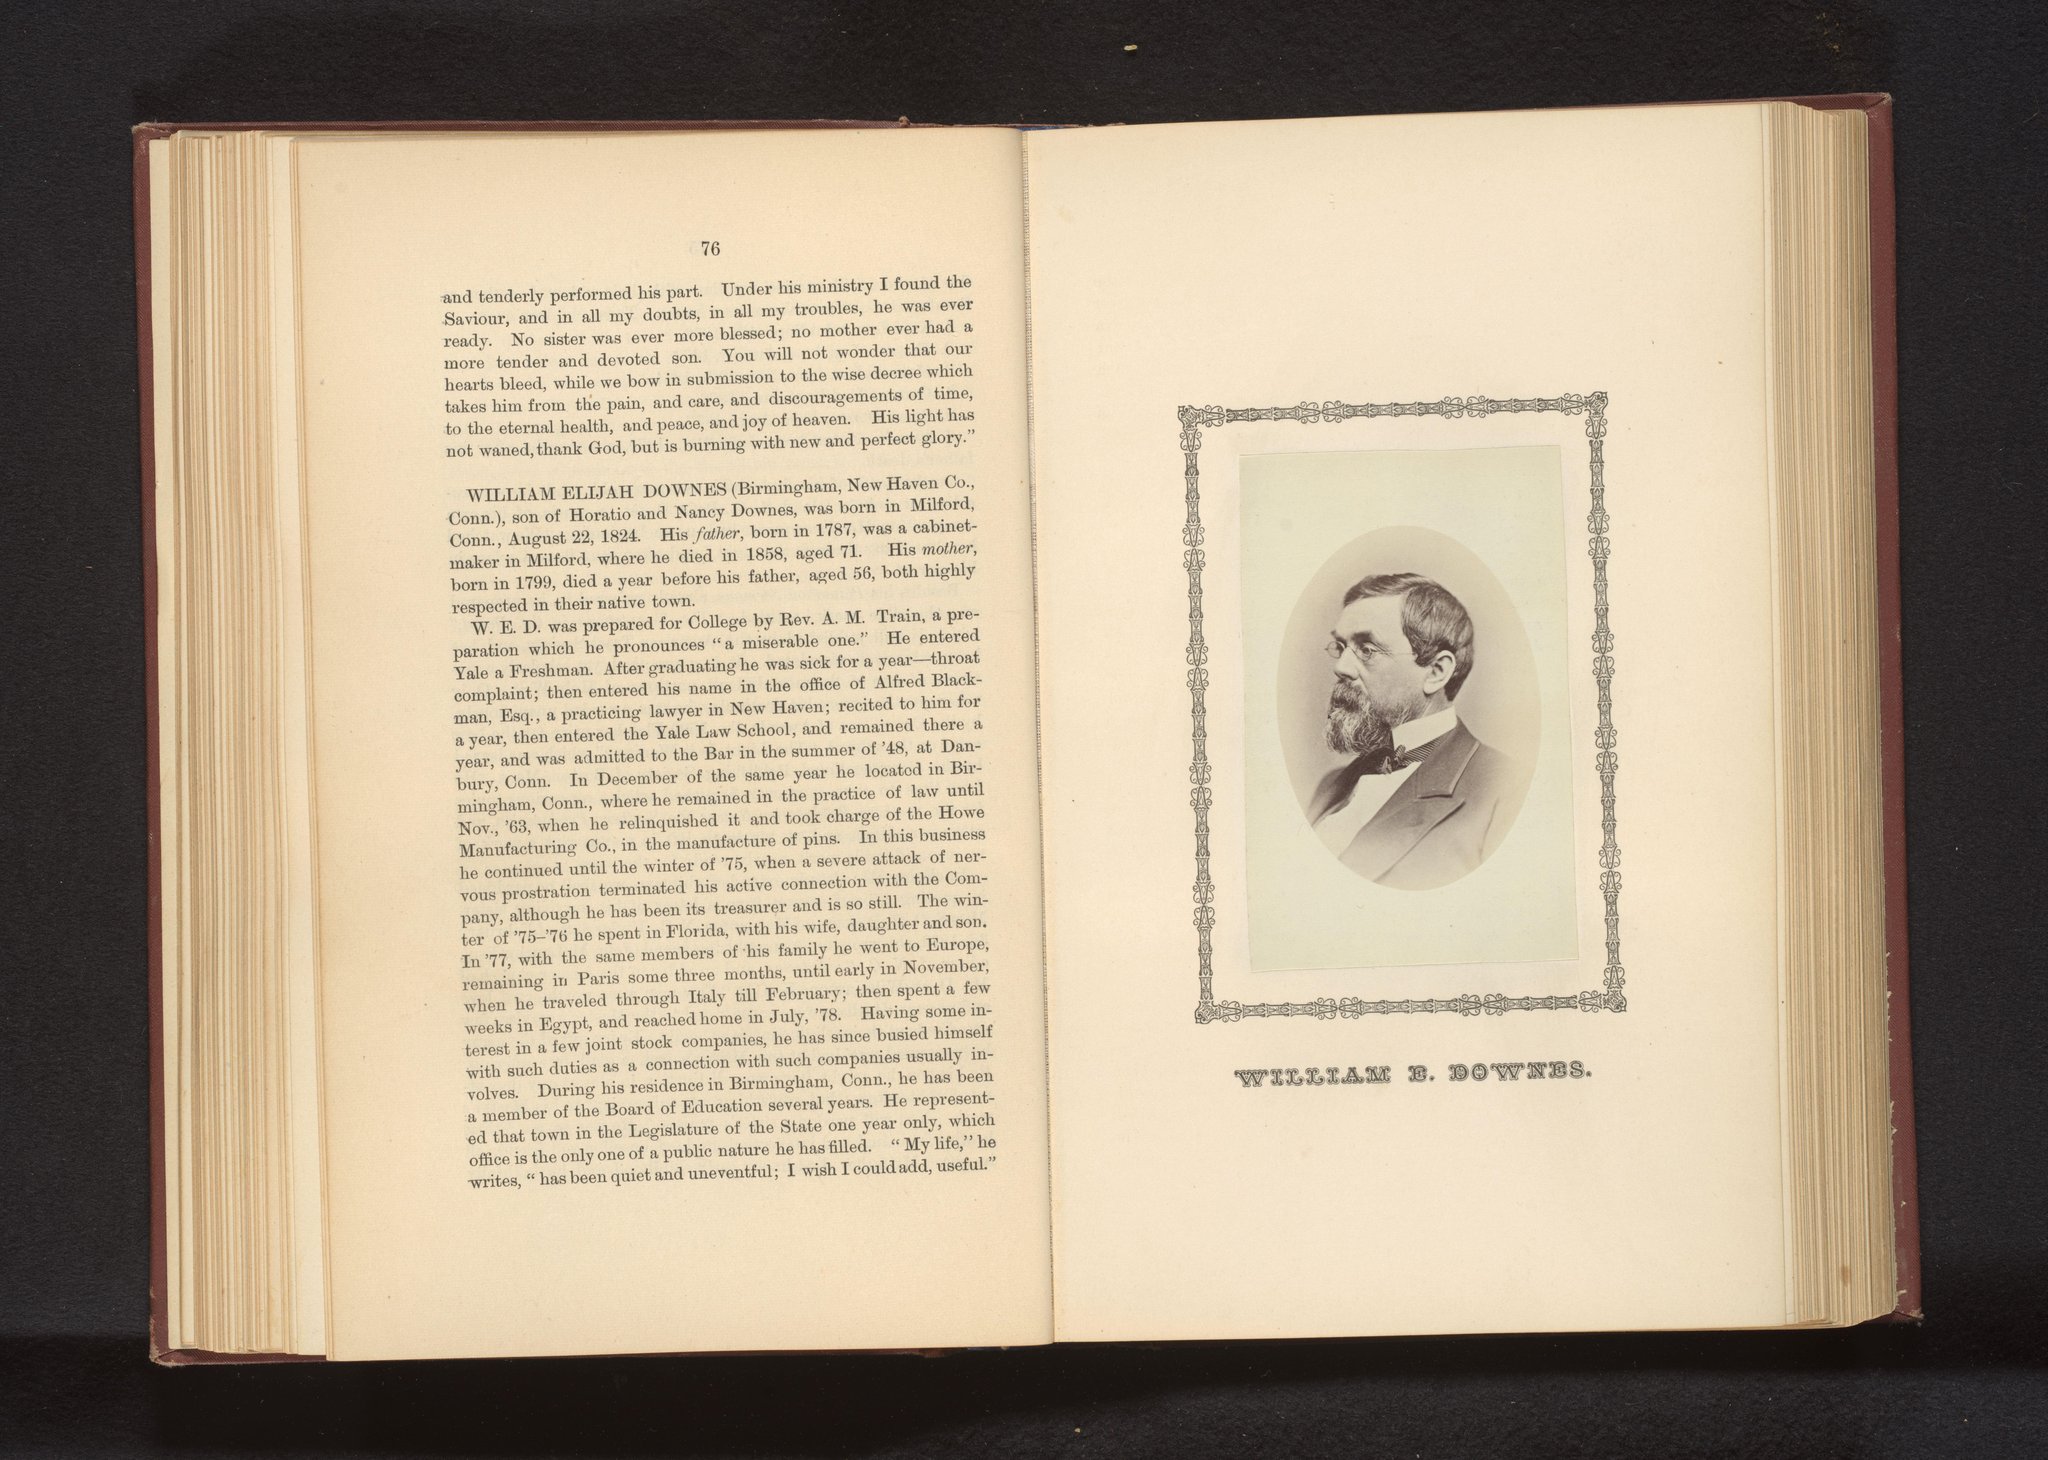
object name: photograph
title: William E. Downes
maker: Anonymous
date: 1876-1881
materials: photographic support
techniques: albumen print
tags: adult man